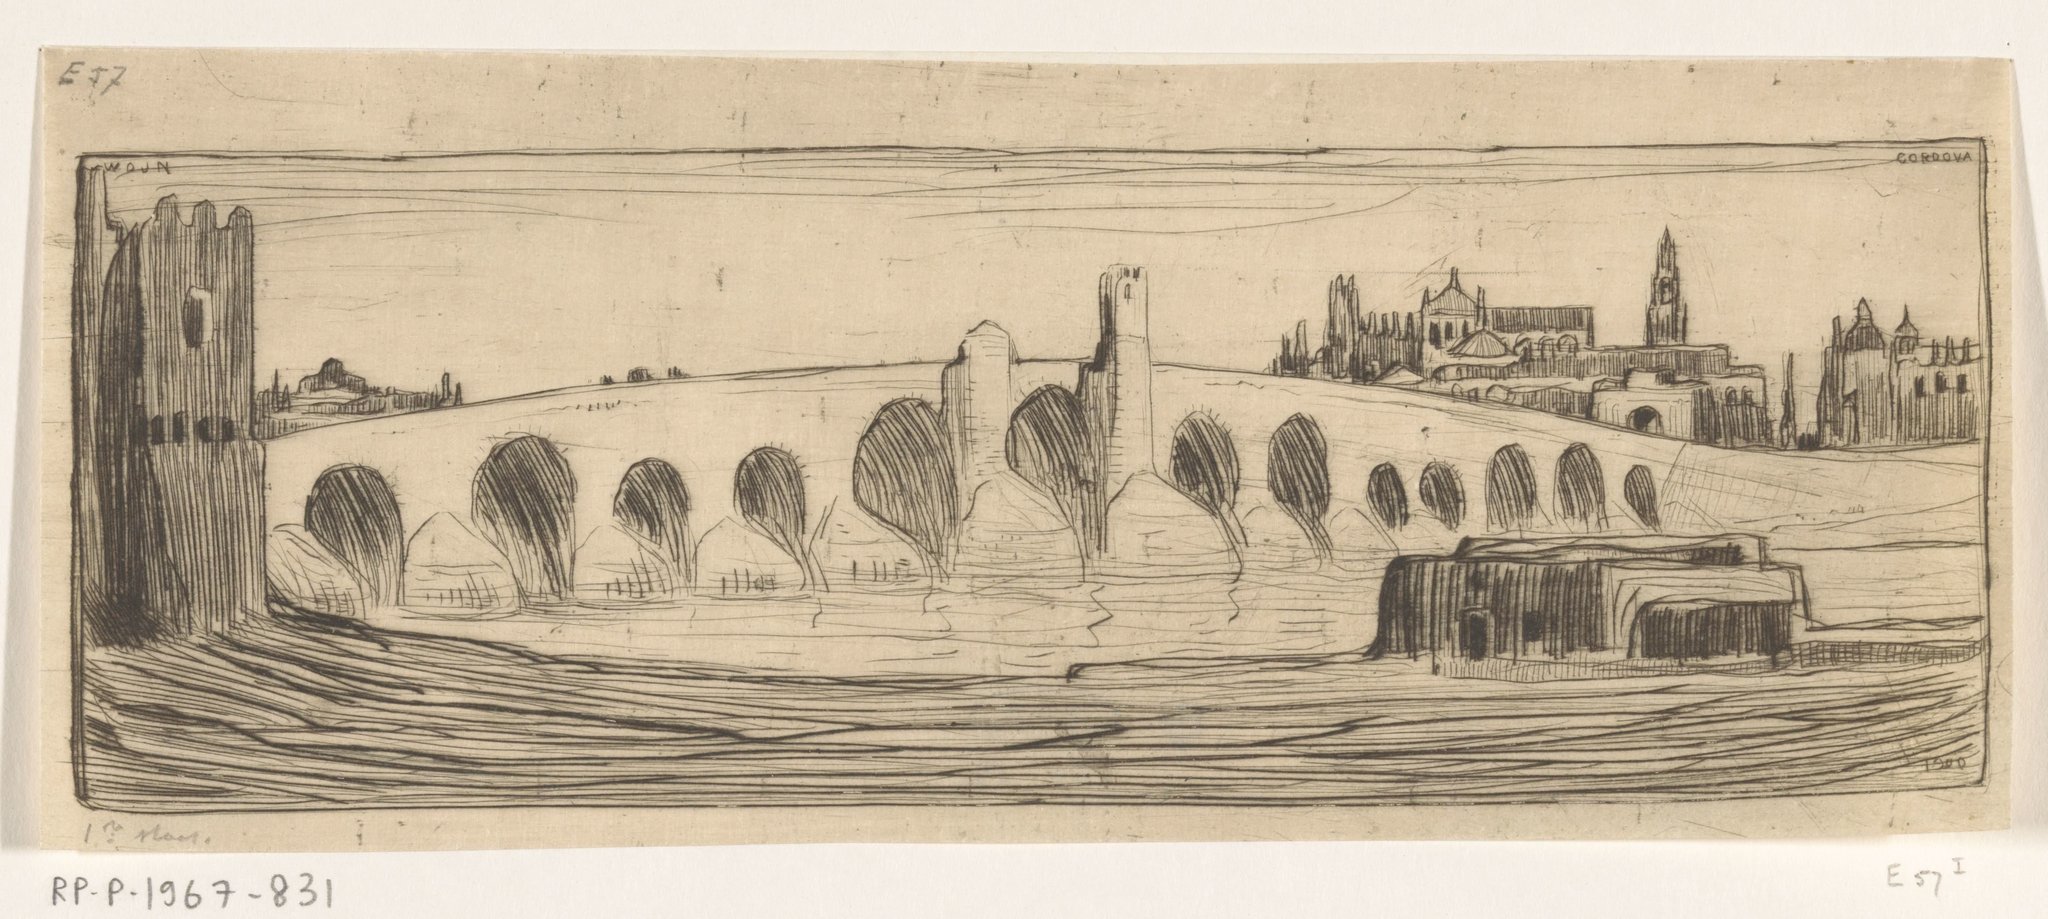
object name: print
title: Romeinse brug over de Guadalquivir in Córdoba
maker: wijnand otto jan nieuwenkamp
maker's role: draughtsman, print maker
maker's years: 1874-1950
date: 1901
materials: paper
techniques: zinc etching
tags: bridge in city across river, canal, etc.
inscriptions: collector's mark: Lugt 2228, collector's mark: Lugt 2760